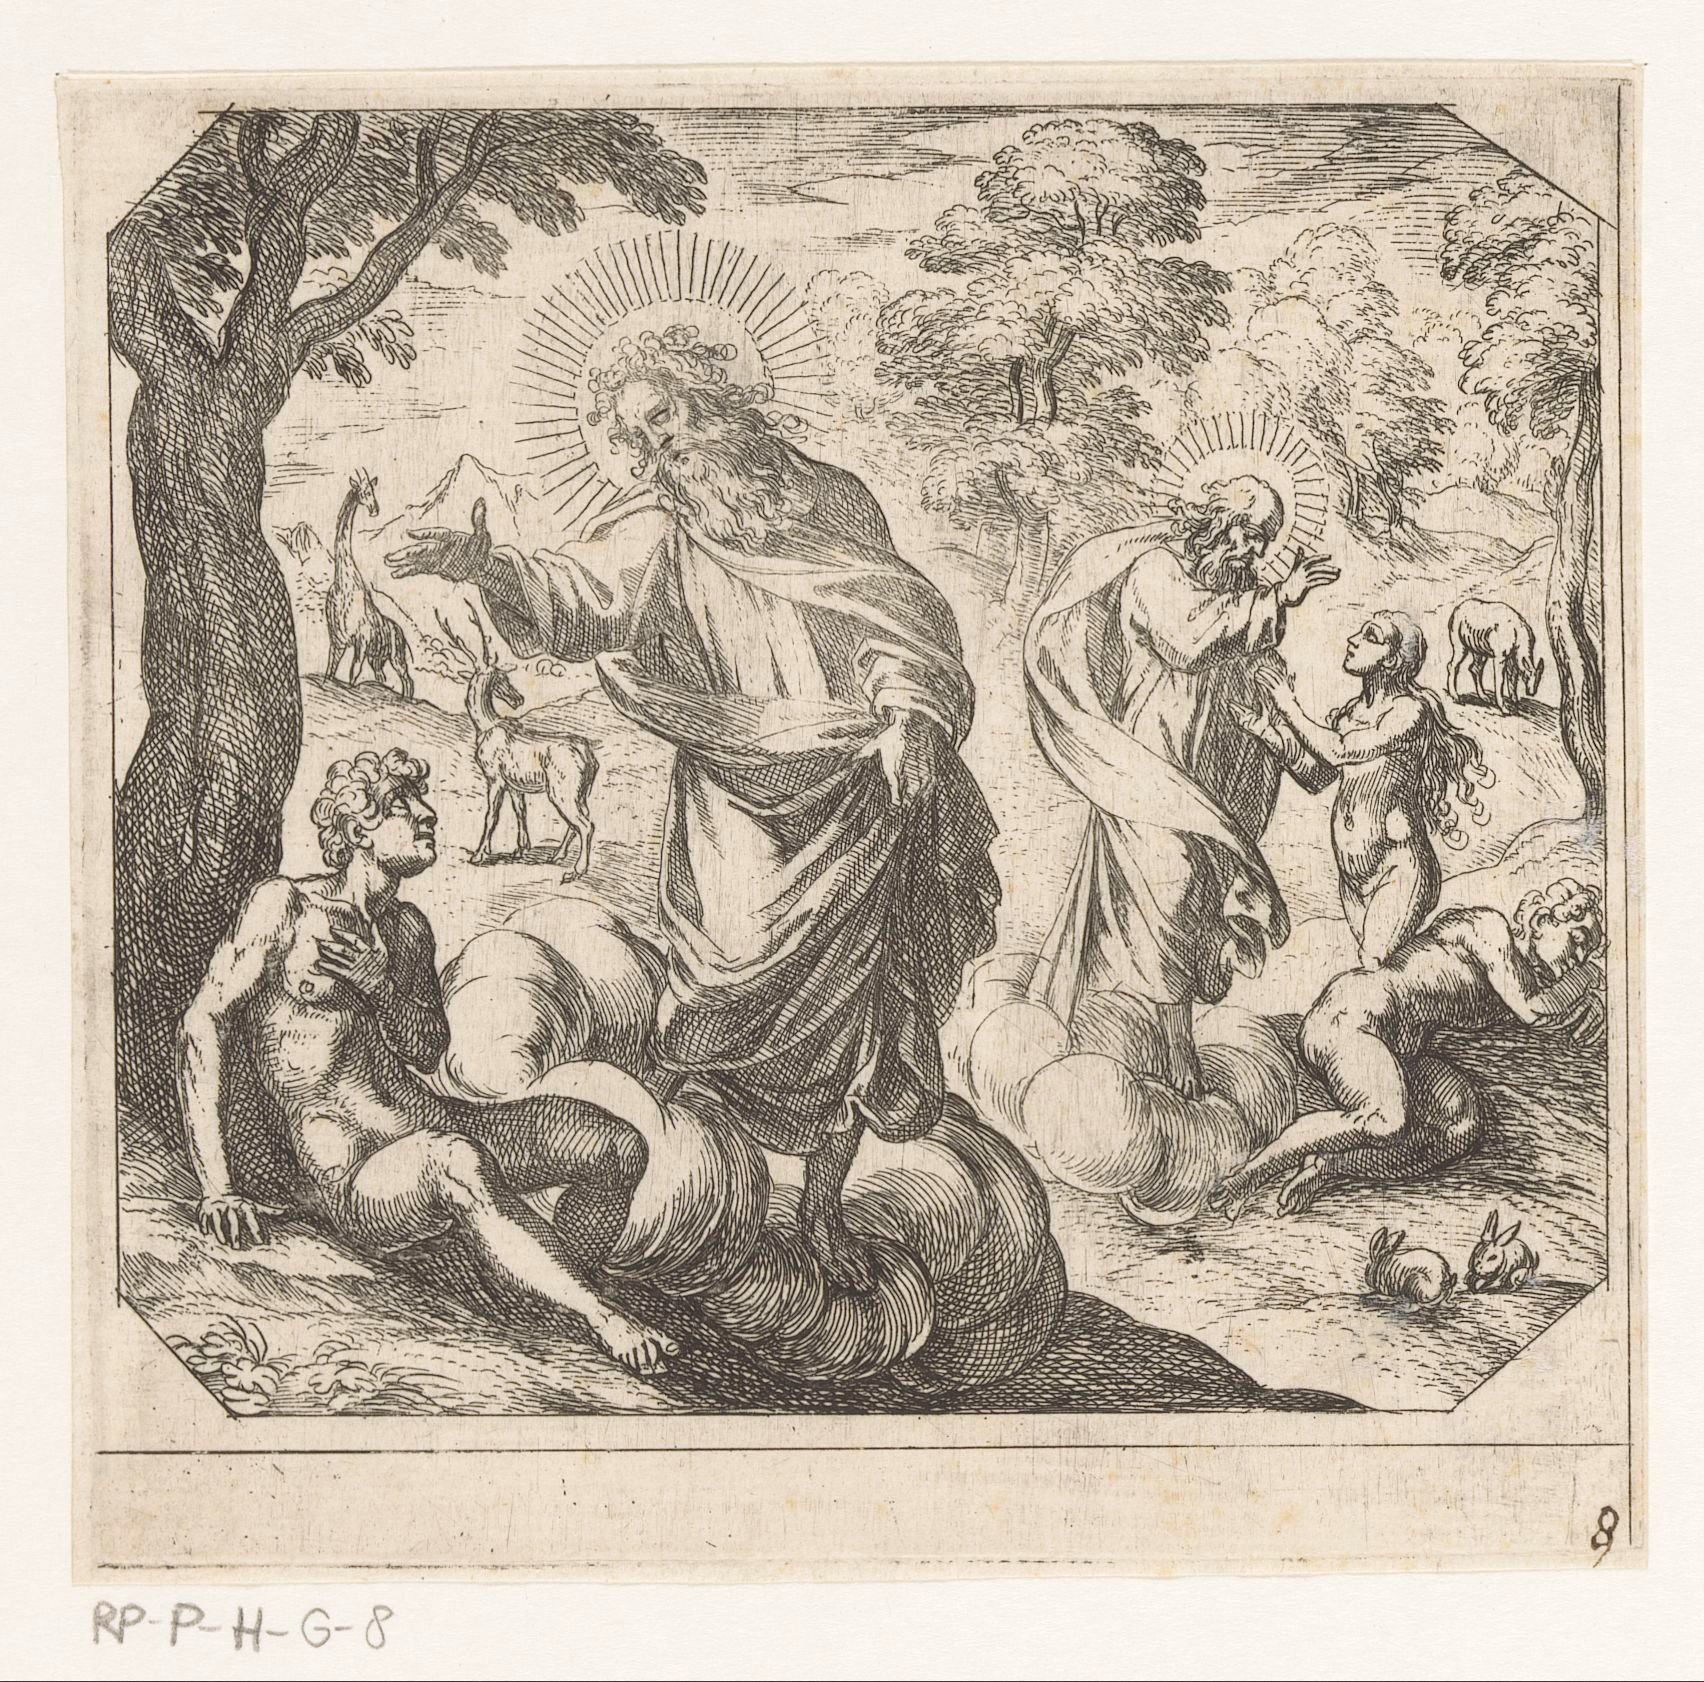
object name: print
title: De schepping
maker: antonio tempesta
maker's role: draughtsman, painter, print maker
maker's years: 1555-1630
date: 1565-1630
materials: paper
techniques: etching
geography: vatican city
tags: creation of man; the garden of eden (genesis 1:26 - 2), creation of eve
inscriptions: number: ‘8’, collector's mark: ‘Hinloopen’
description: Deze prent maakt deel uit van een serie van twaalf prenten van de schepping. De prenten zijn deels naar ontwerpen van Rafaël voor de Loggia van Rafaël in het Vaticaan, en deels naar prenten door Nicolaes de Bruyn naar ontwerpen van Maerten de Vos (zie: Holl. Dutch. vol. 45 nr. 1-10).